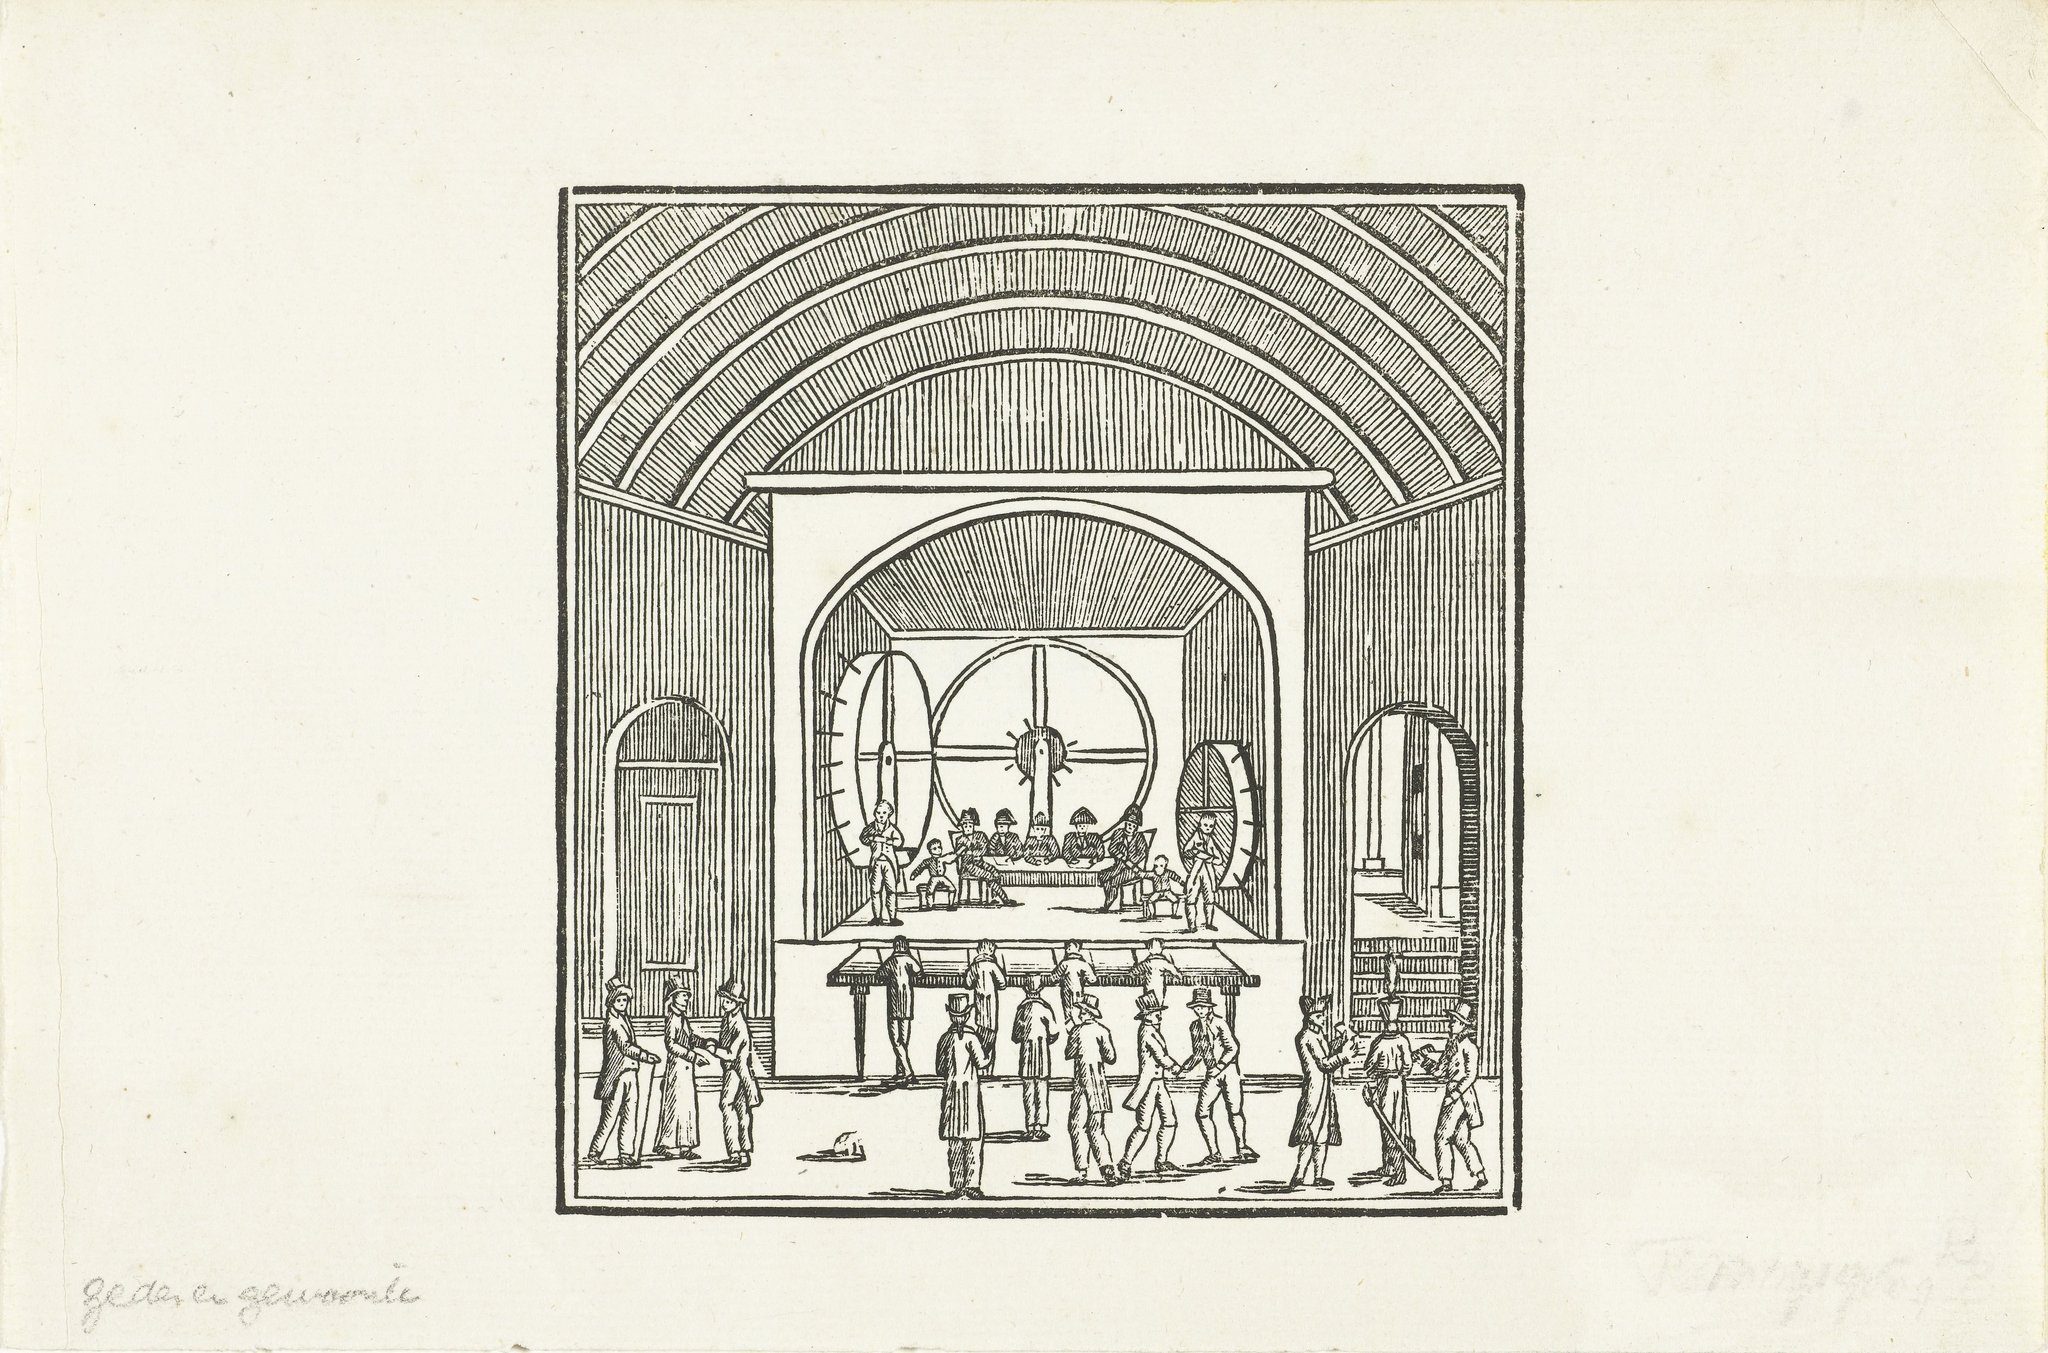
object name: print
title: Loterij te Den Haag, ca. 1750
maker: Anonymous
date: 1740-1760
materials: paper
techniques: woodcut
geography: northern netherlands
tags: raffle, lottery, the hague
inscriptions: collector's mark: Lugt 2233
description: Het trekken van de loten tijdens een loterij, ca. 1750. Op een podium trekken twee kinderen de loten uit raderen in de loterijzaal in het Hof te Den Haag.